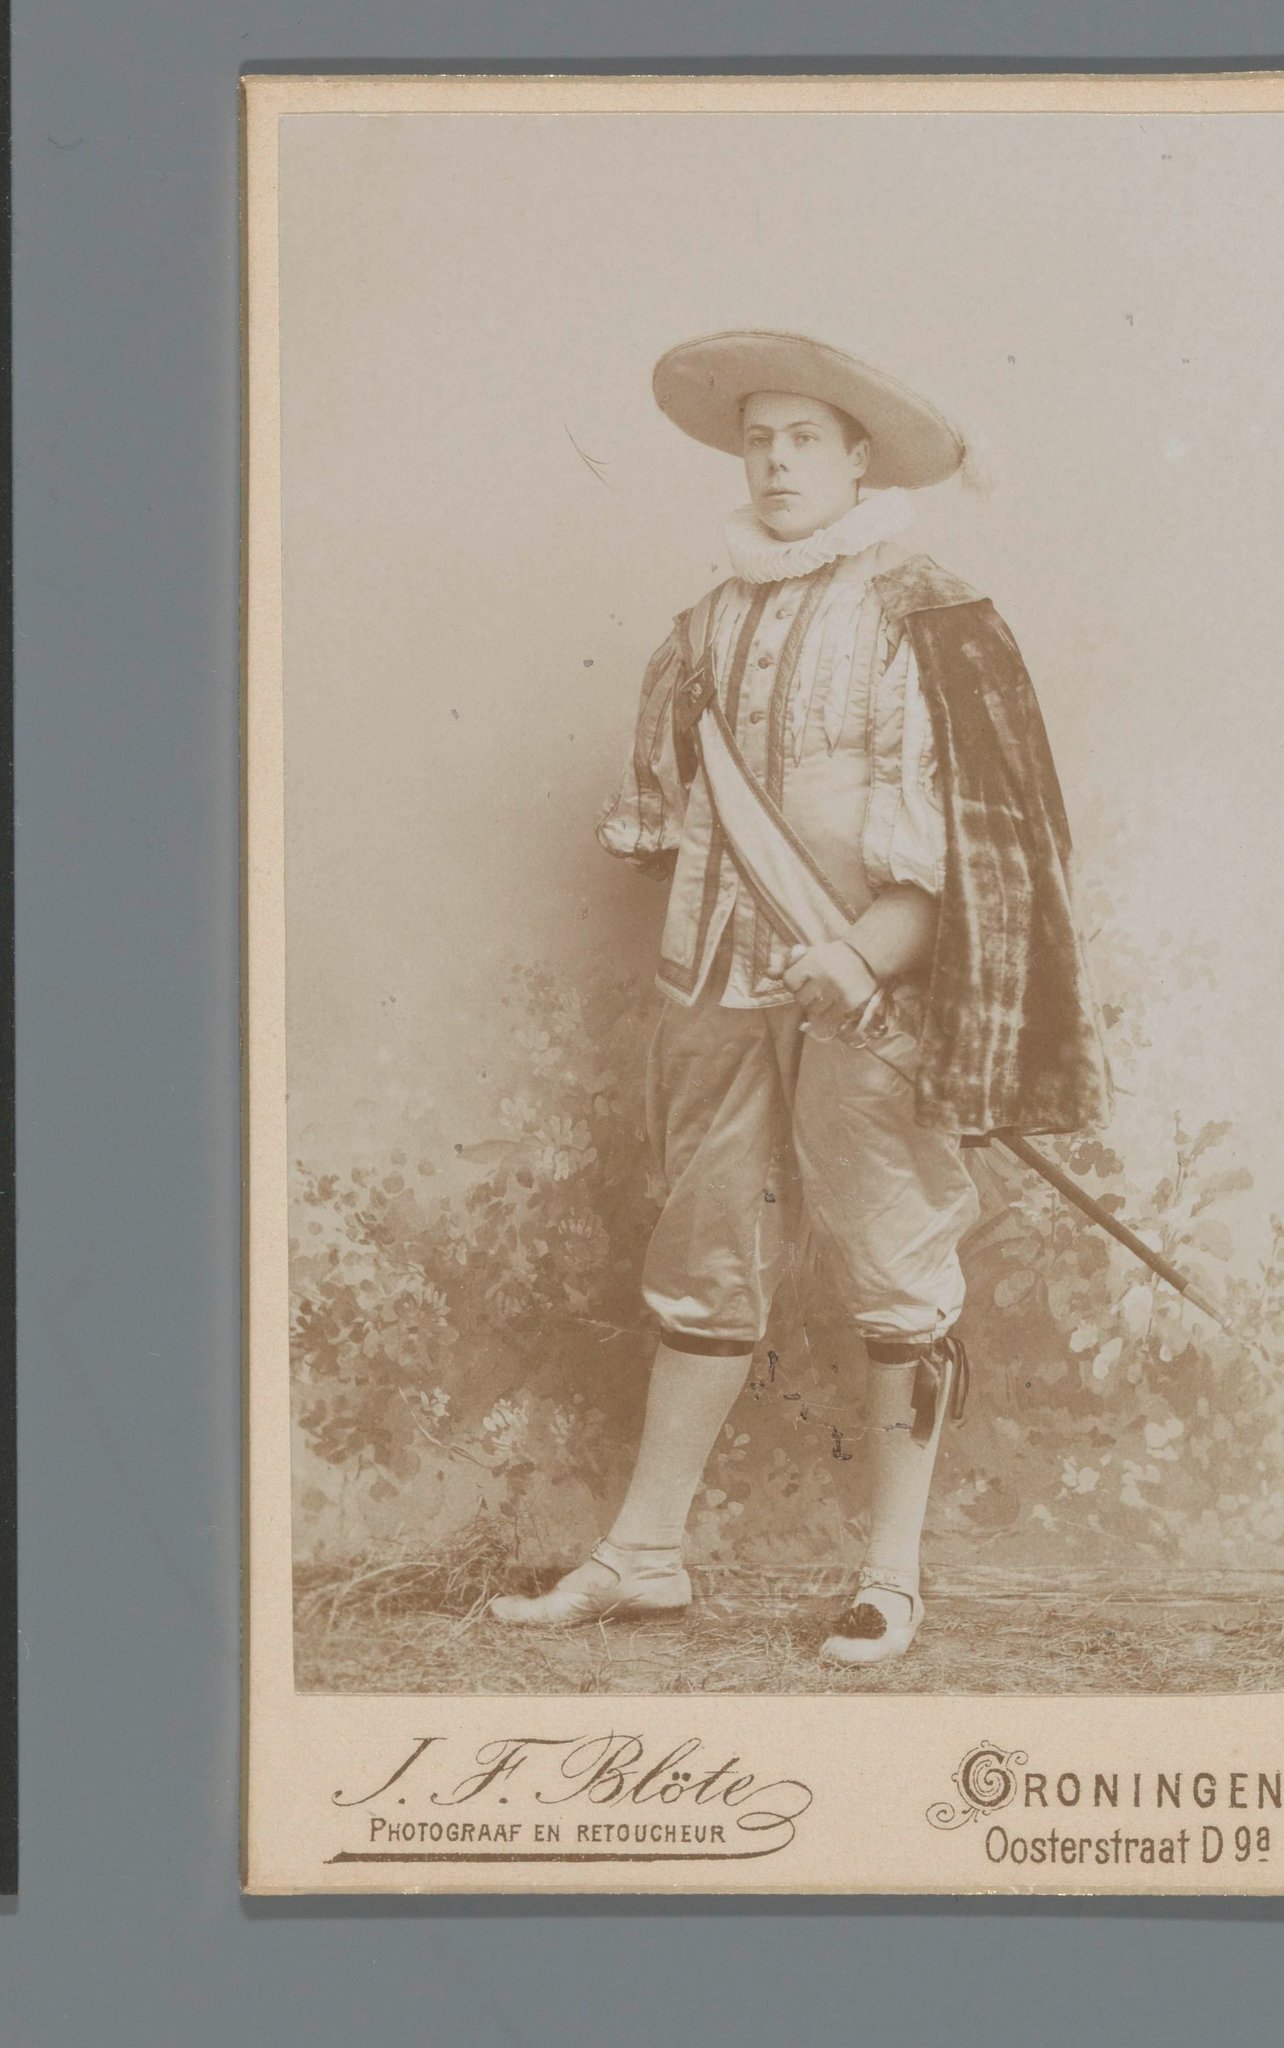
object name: photograph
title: Portret van een onbekende Groningse student in maskeradekostuum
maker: jan frederik blöte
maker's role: fotograaf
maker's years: 1865-1956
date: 1896-1900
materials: paper, cardboard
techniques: collodion silver print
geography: groningen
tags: students' pageant, costumes used in pageants, anonymous historical person portrayed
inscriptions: inscription: ‘J.F. Blöte/ Photograaf en retoucheur/ Groningen/ Oosterstraat D9a’